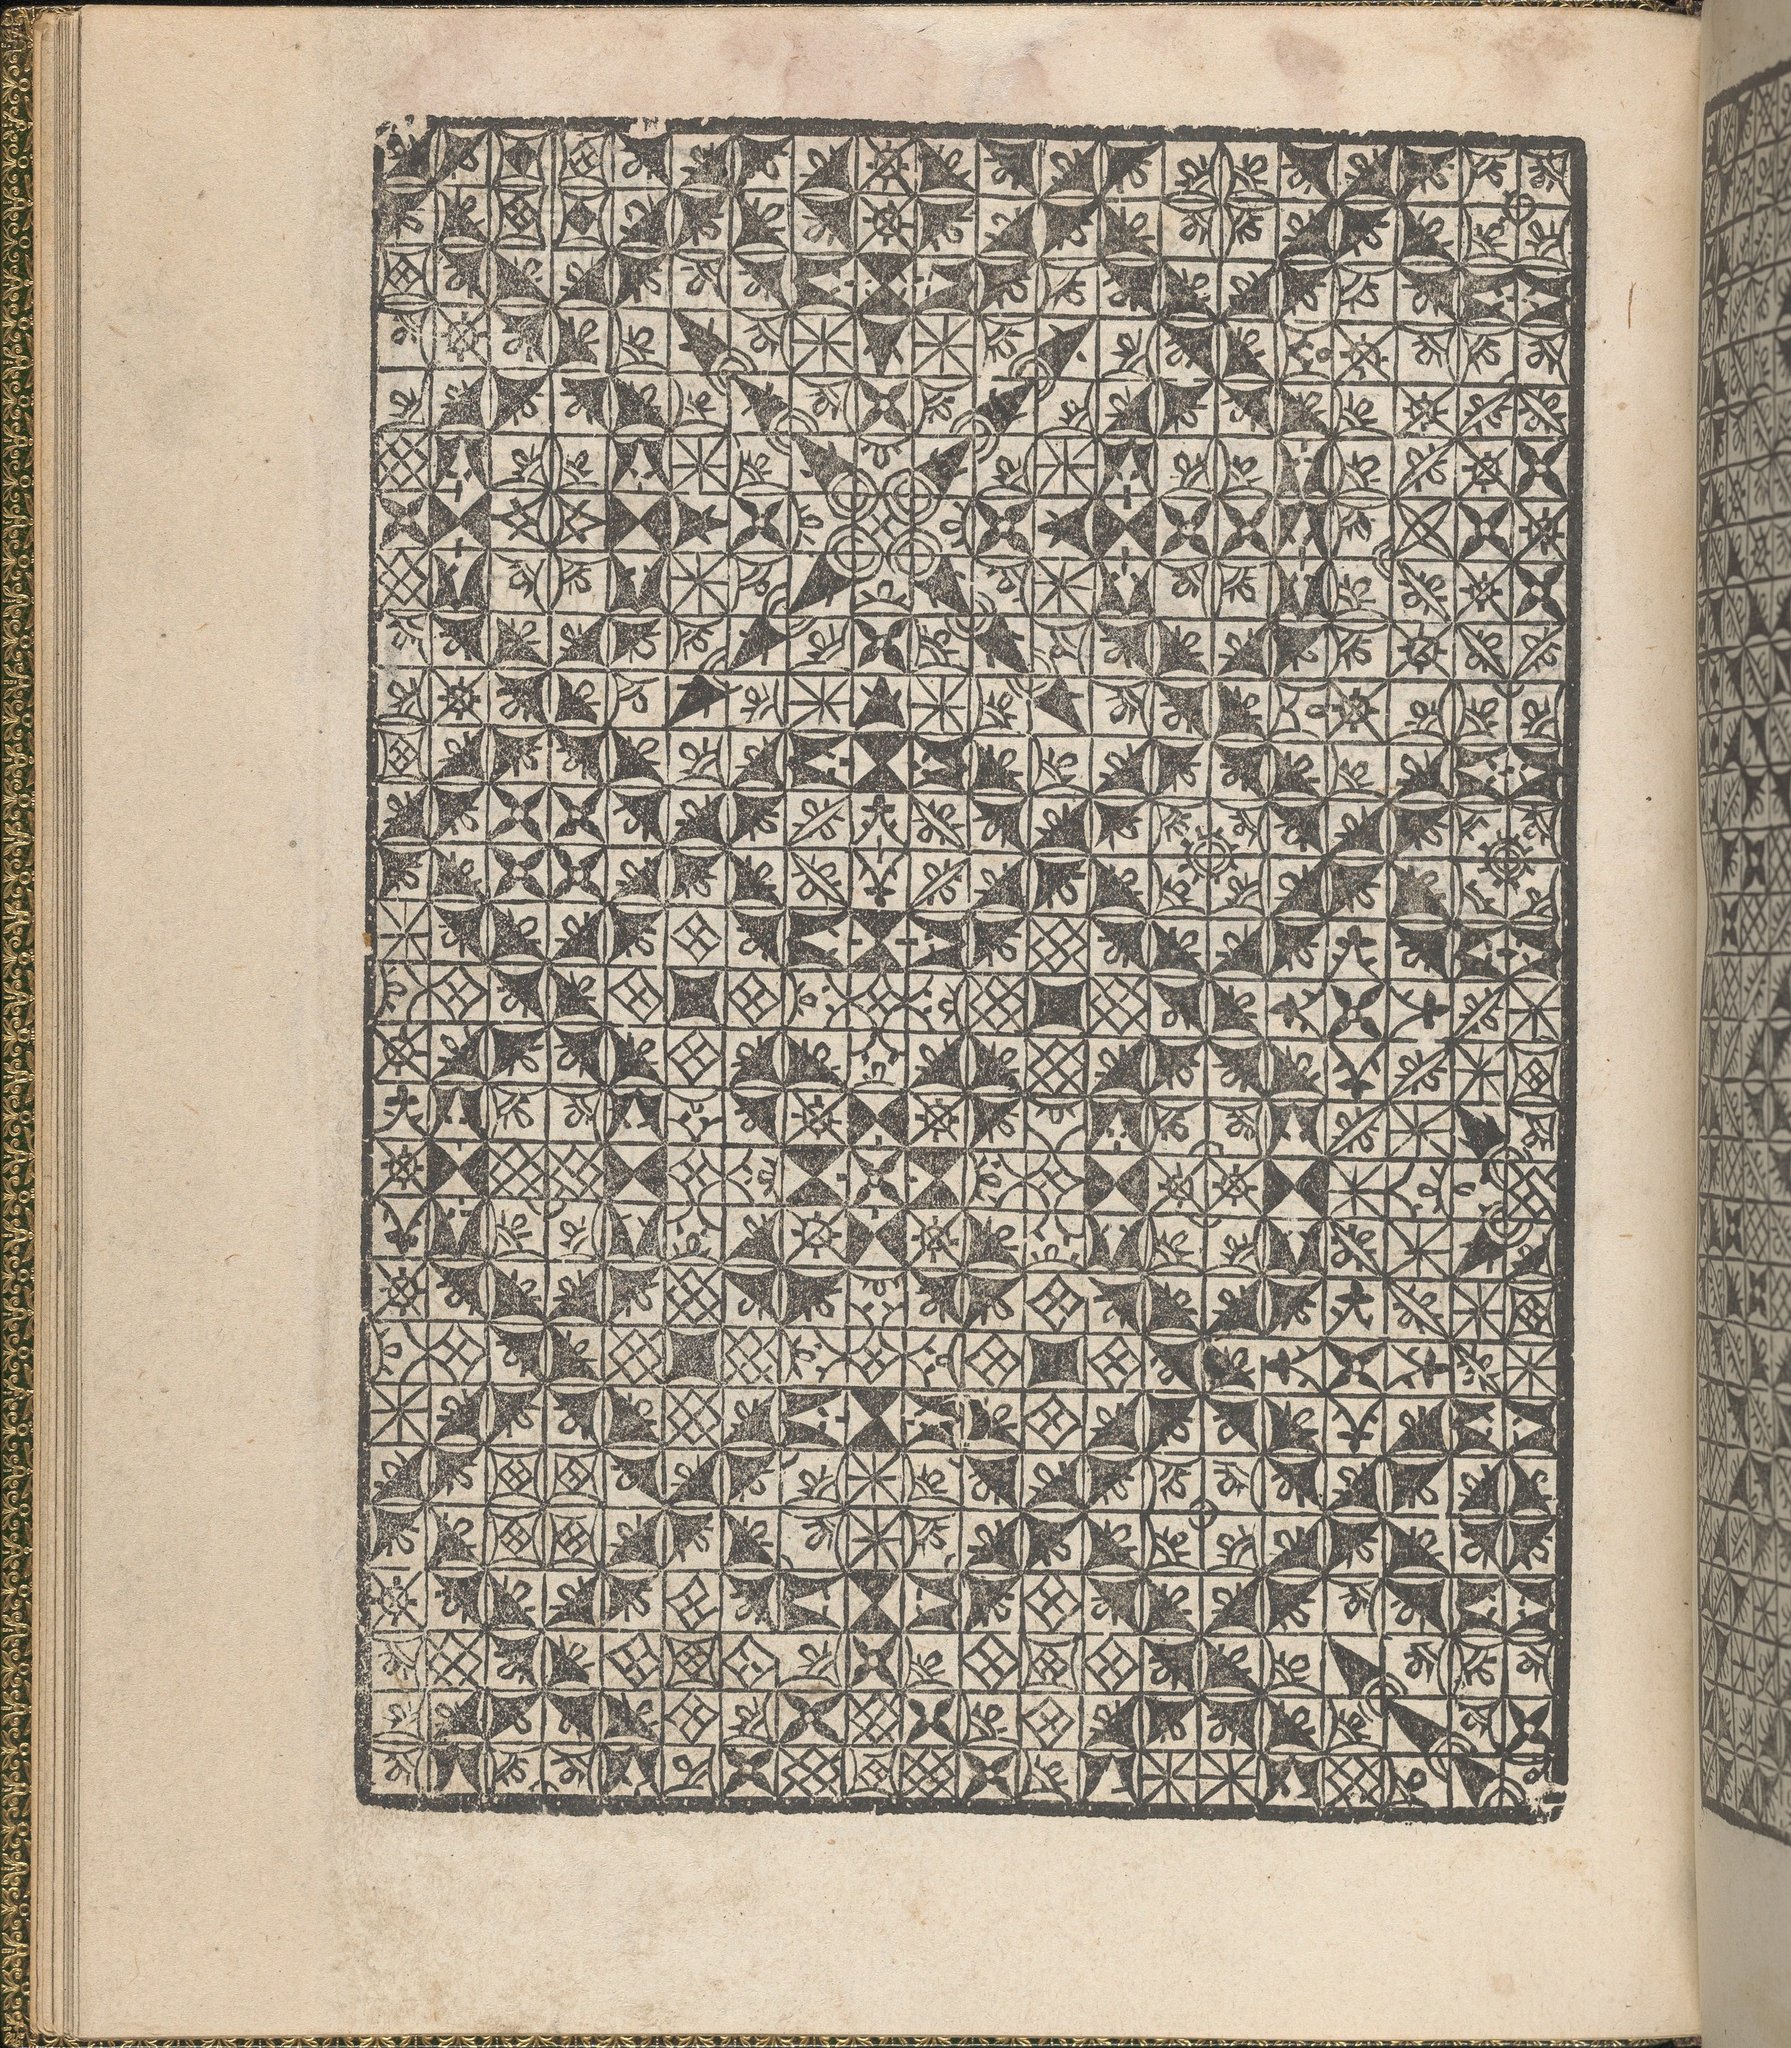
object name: book print ornament architecture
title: Giardineto novo di punti tagliati et gropposi per exercitio & ornamento delle donne (Venice 1554), page 17 (verso)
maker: matteo pagano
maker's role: publisher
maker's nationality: italian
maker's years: 1515-1588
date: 1554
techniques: woodcut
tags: ornament